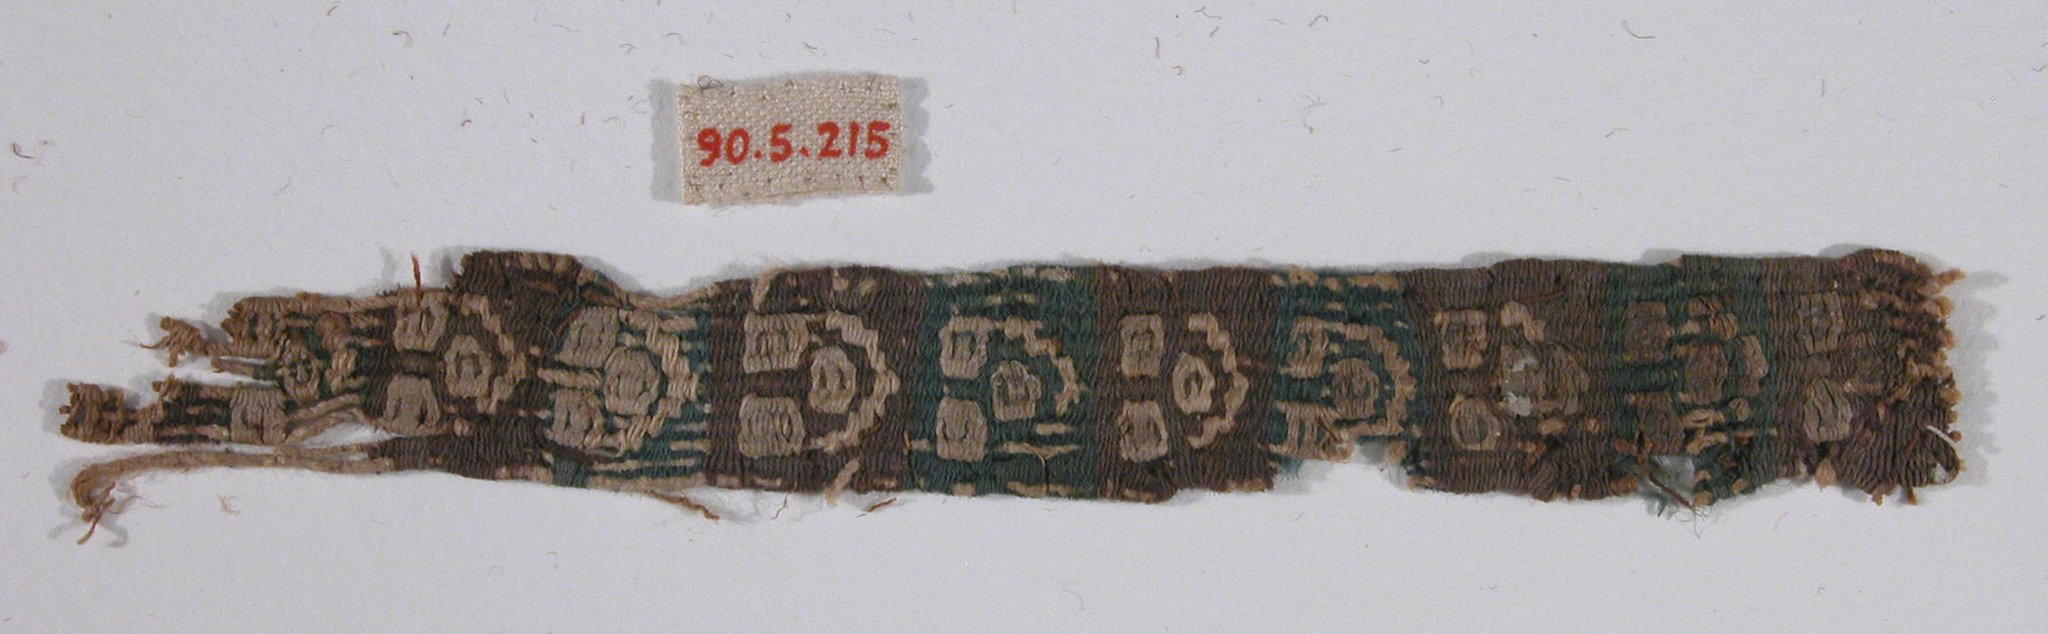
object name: textile fragment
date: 401-600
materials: linen, wool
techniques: weave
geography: egypt